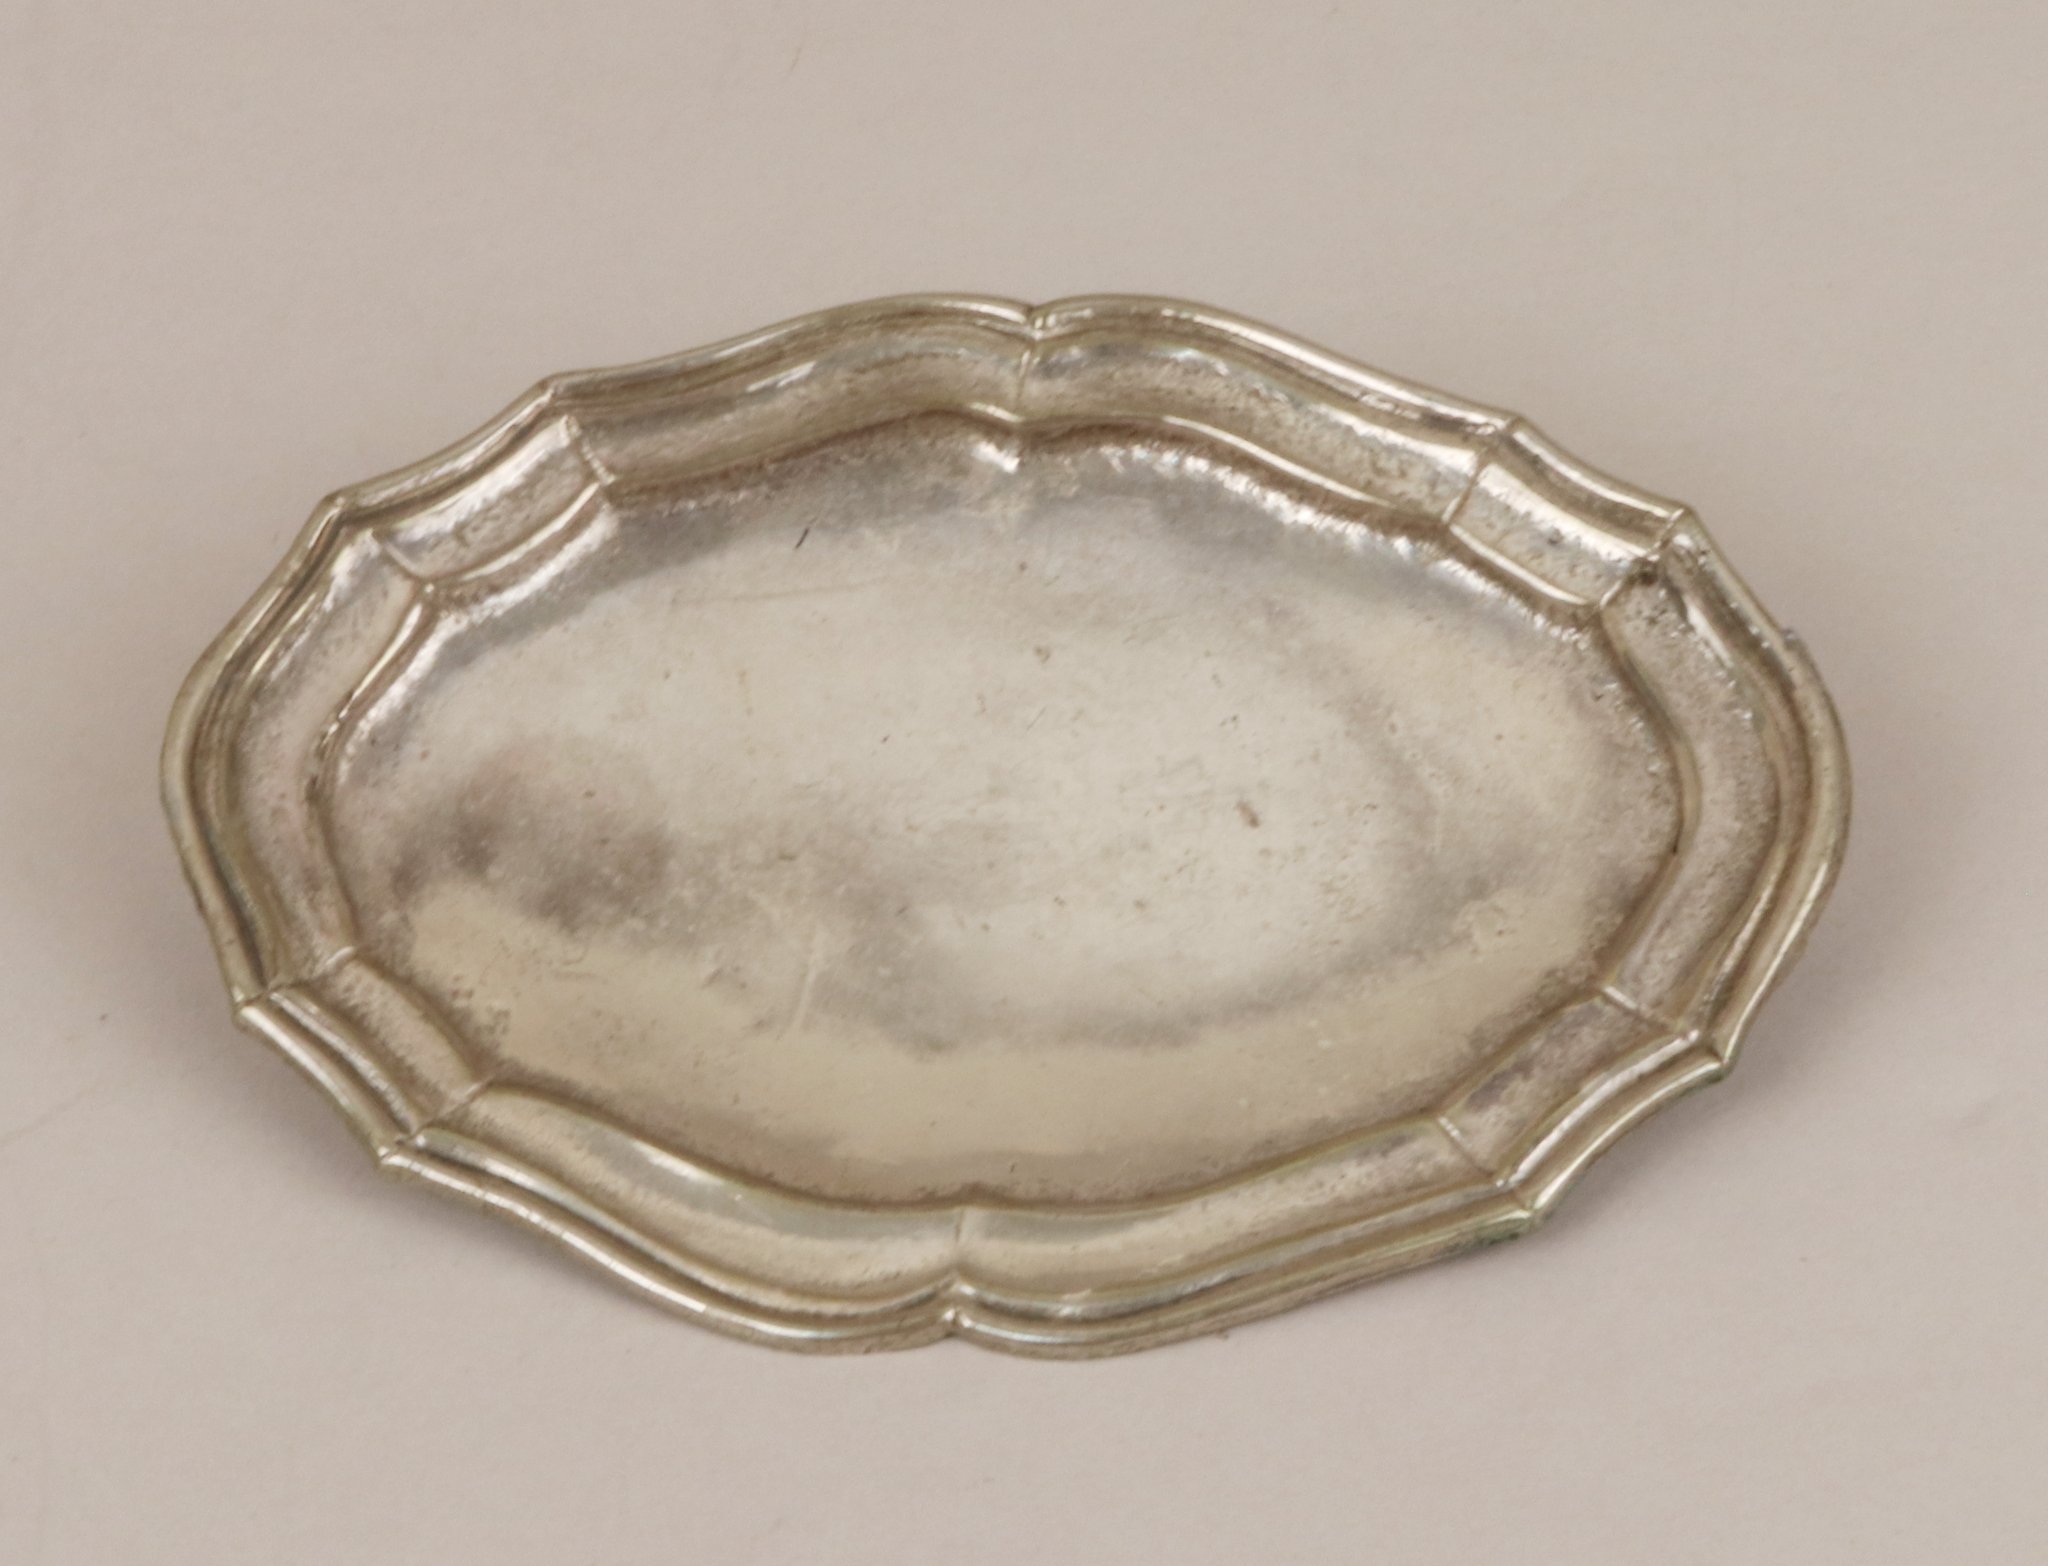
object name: crèche accessory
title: Oval silver platter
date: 1701-1800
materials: silver